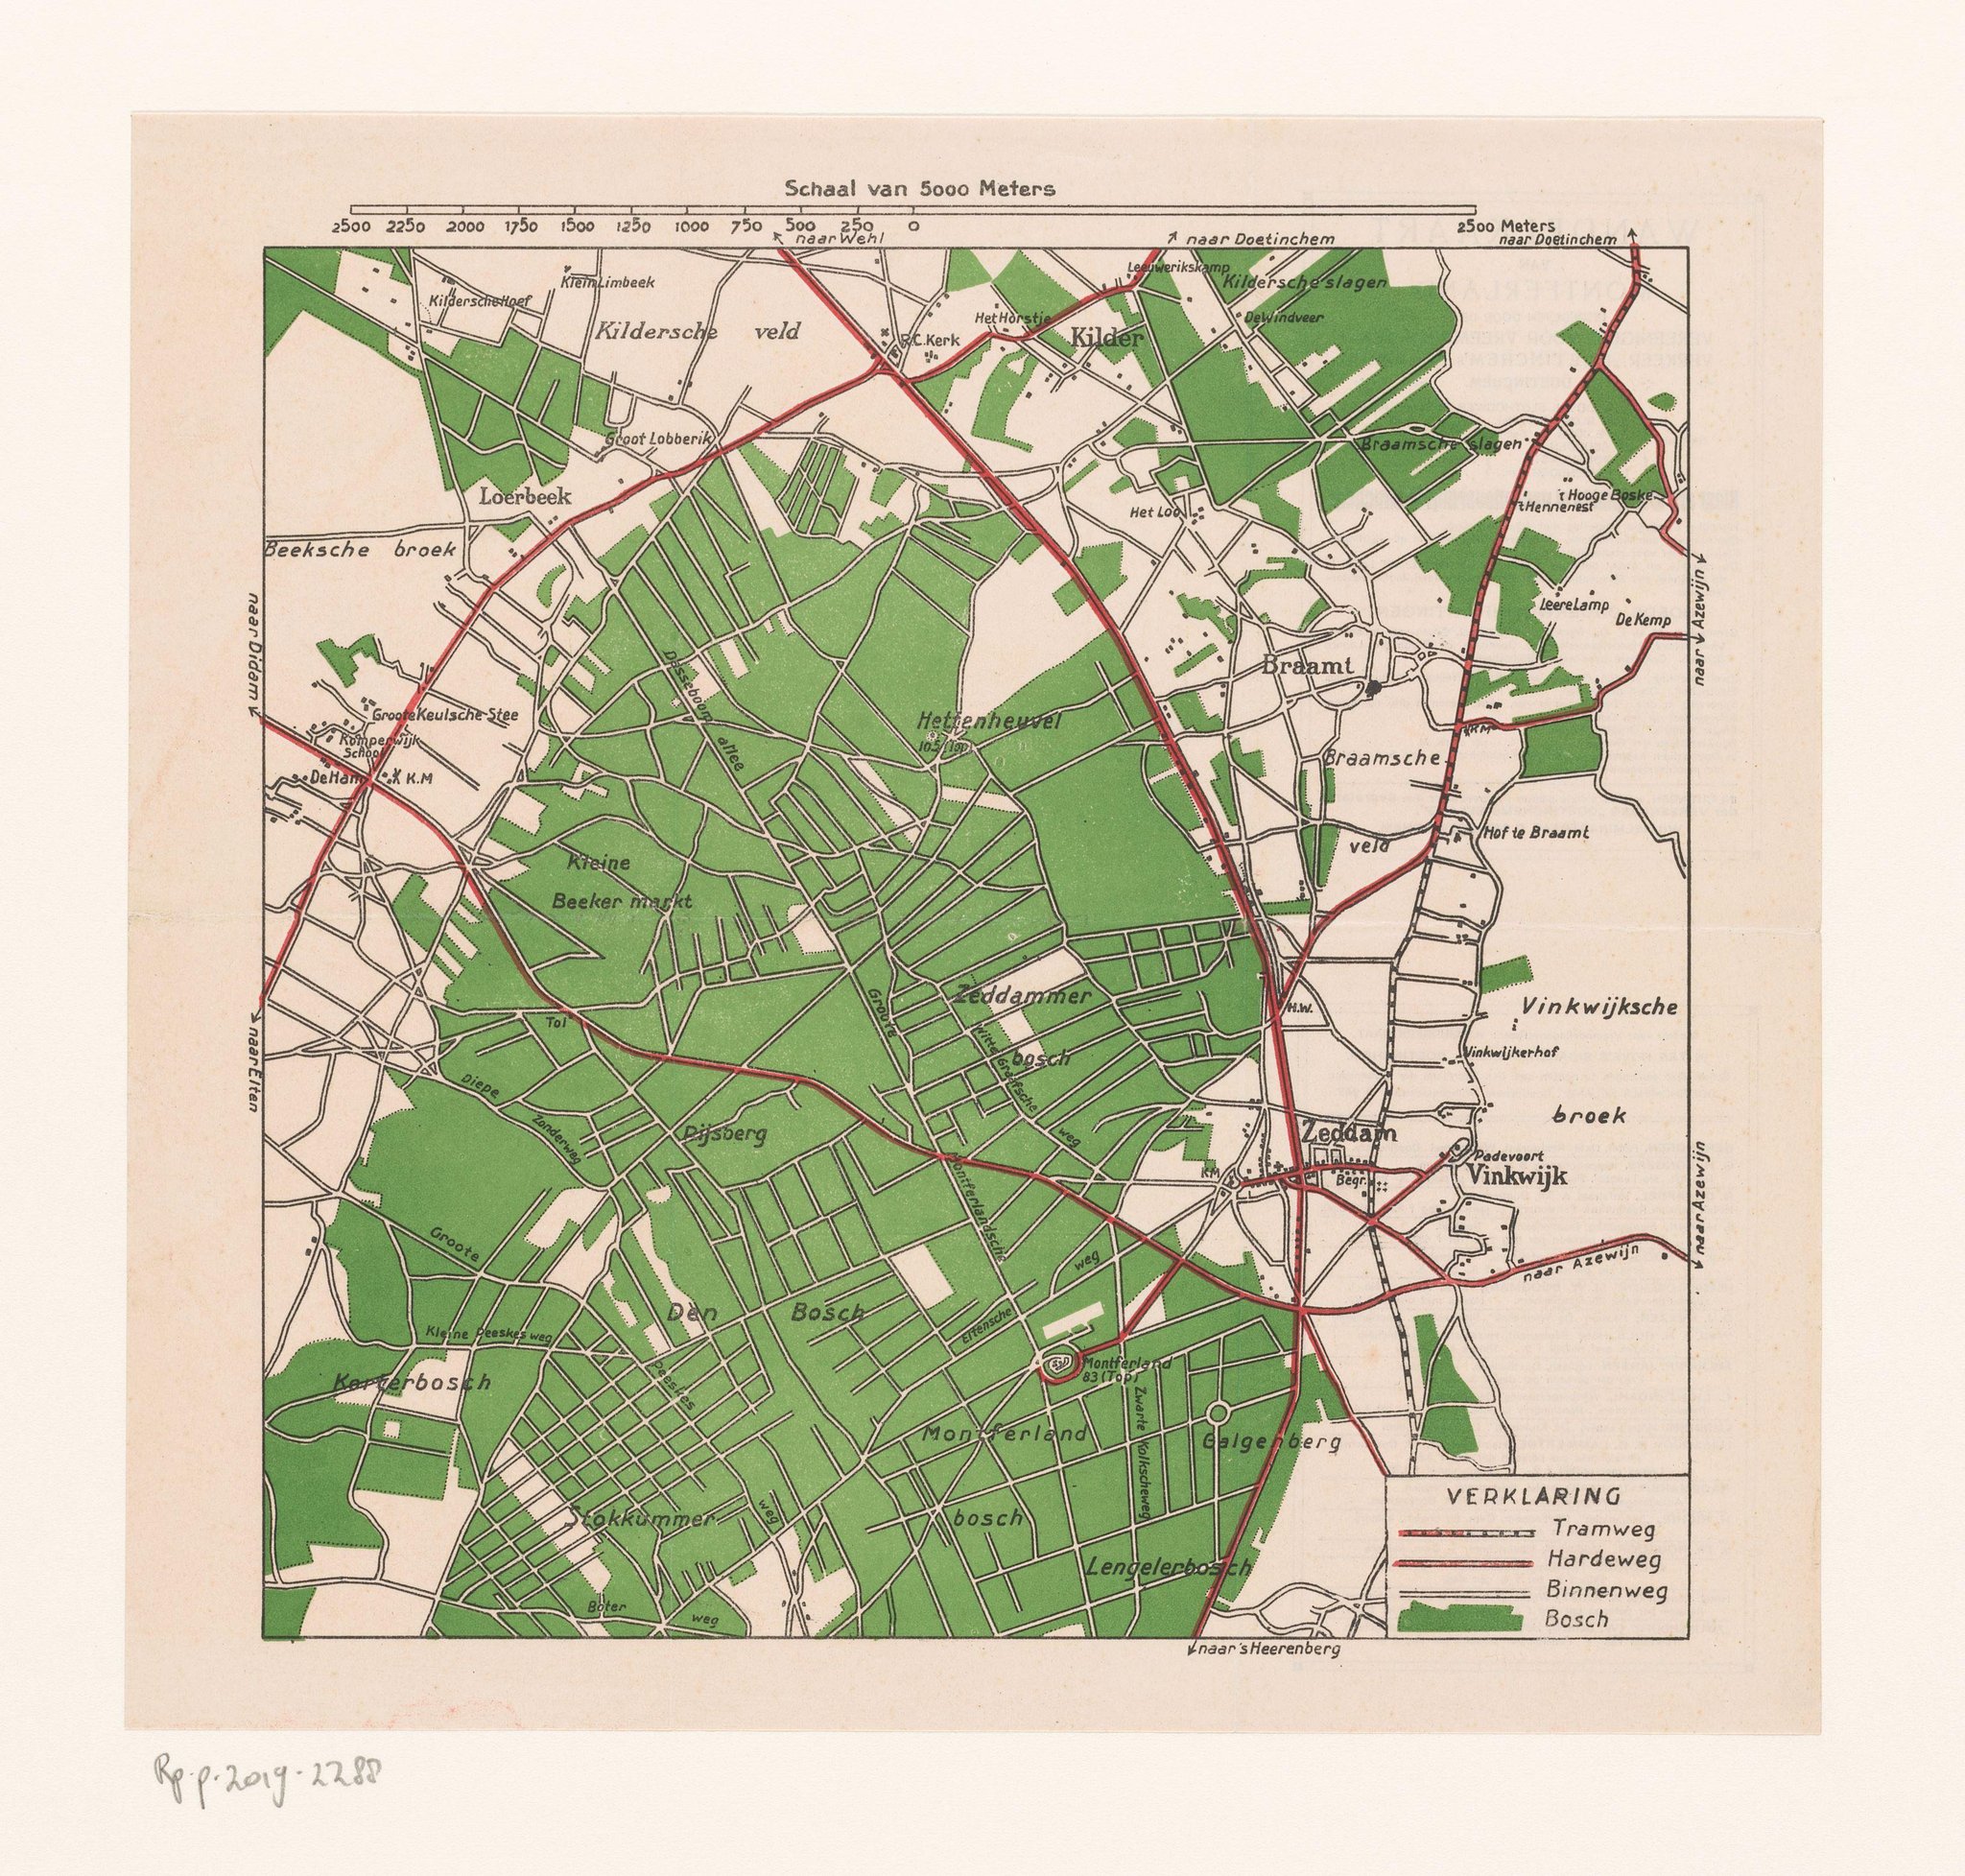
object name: map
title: Kaart van Montferland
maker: Anonymous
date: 1926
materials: paper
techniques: lithograph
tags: maps of separate countries or regions, gelderland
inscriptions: collector's mark: Lugt 2228